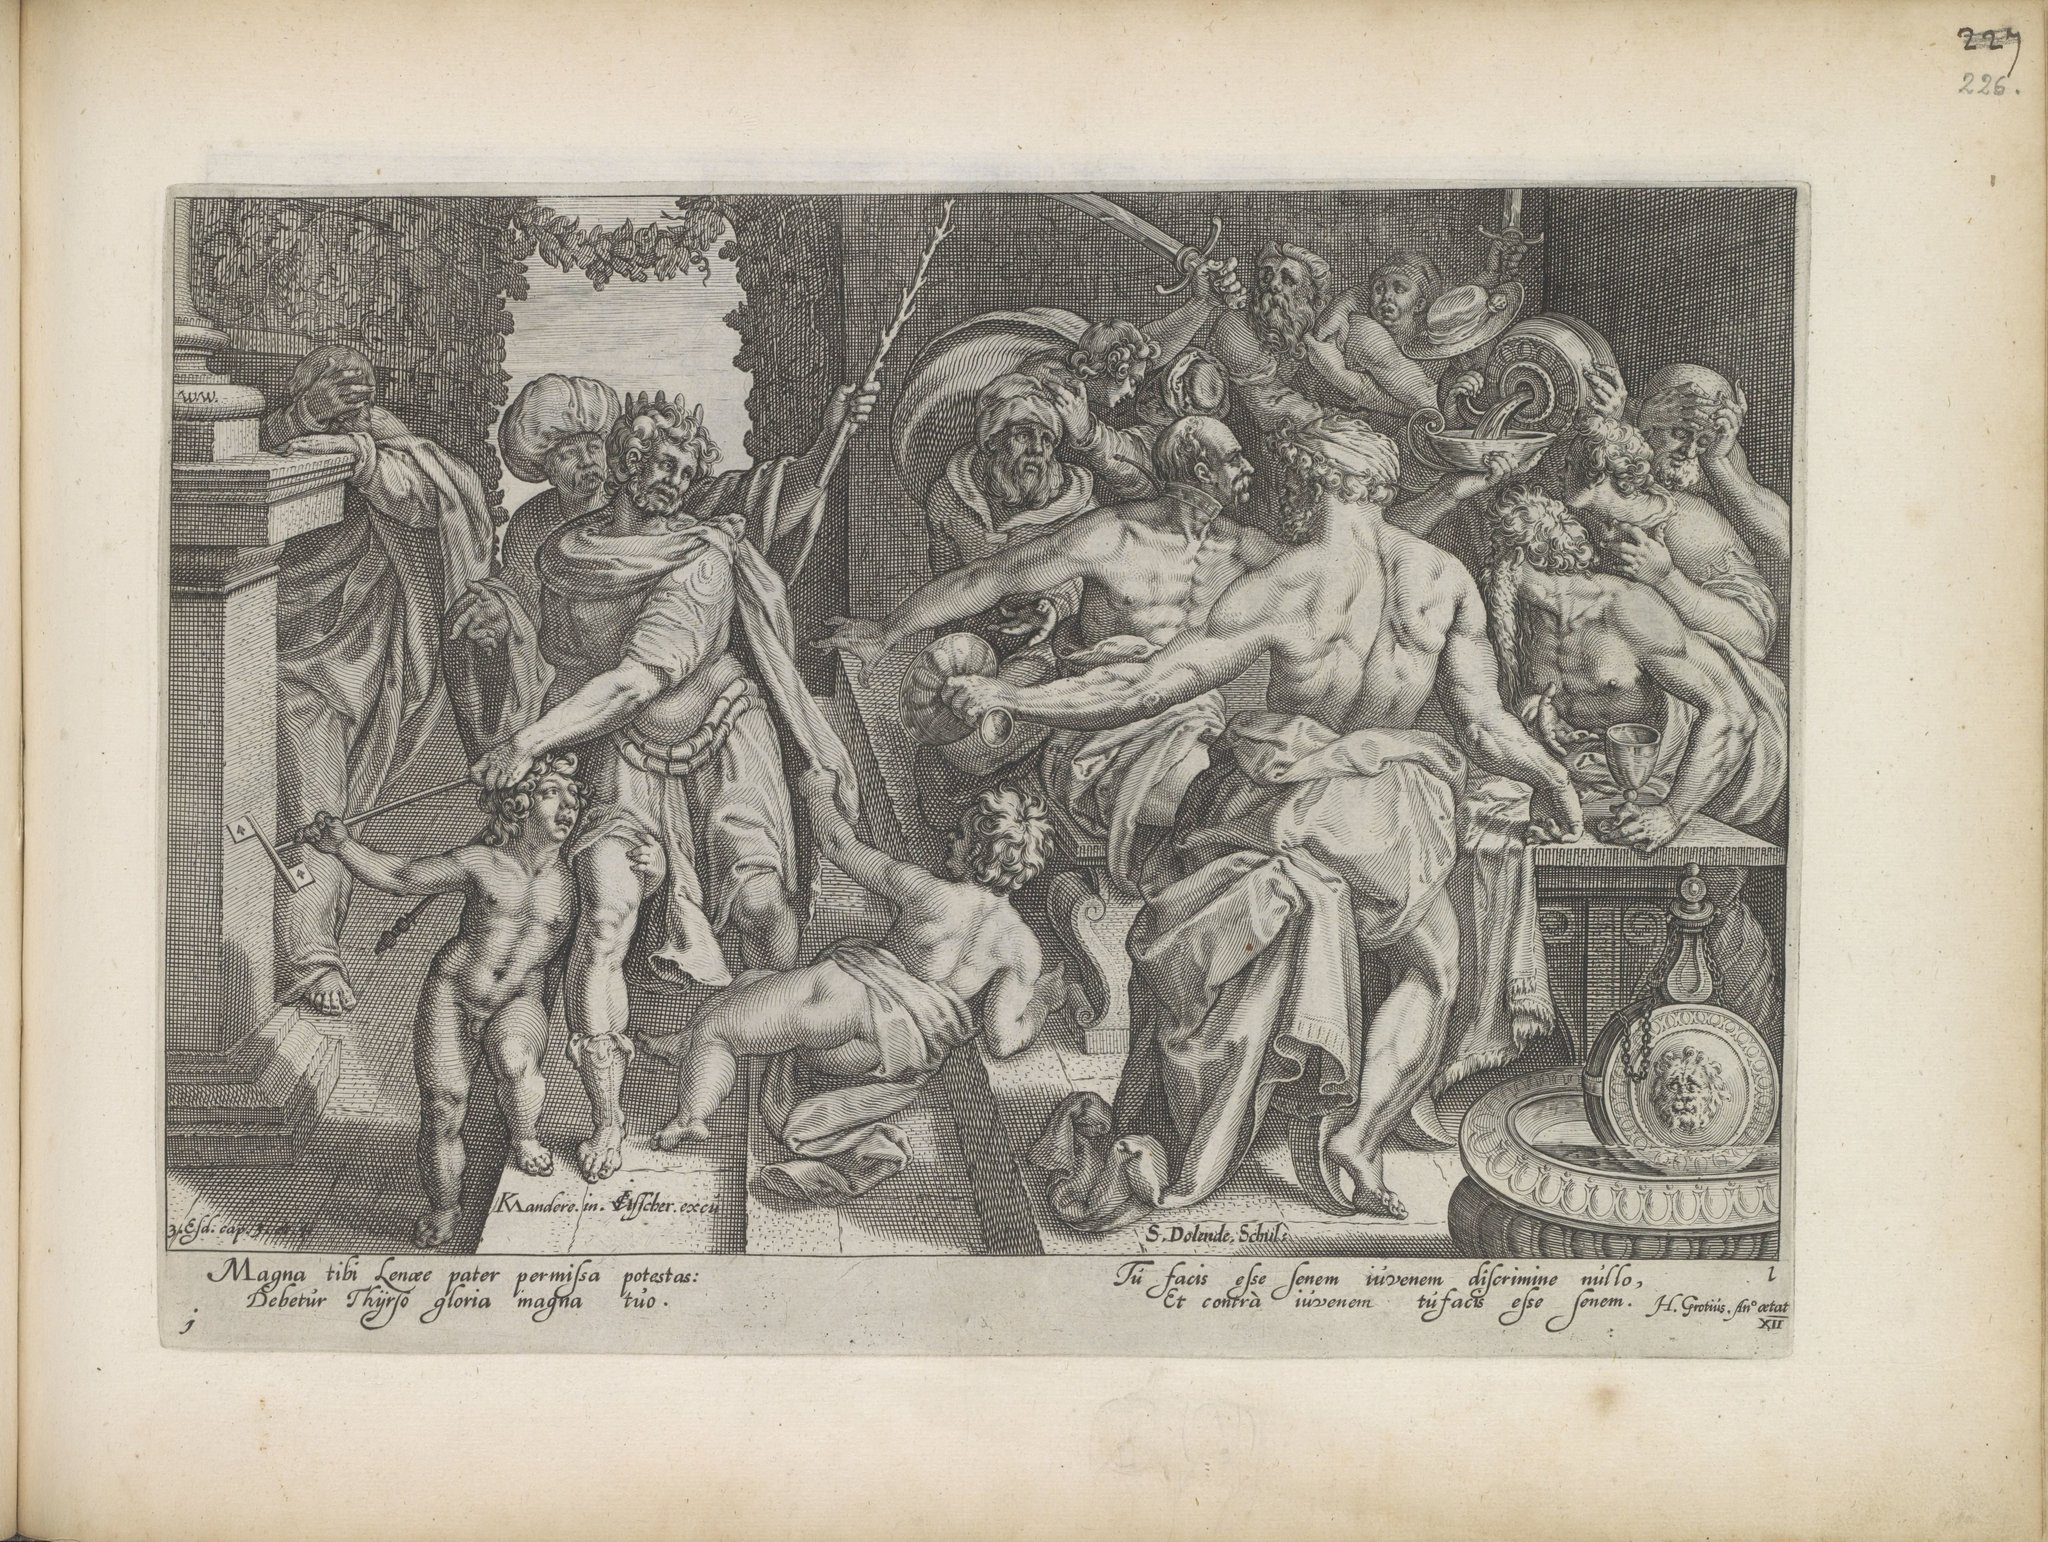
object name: album leaf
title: Macht van wijn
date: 1595-1596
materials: paper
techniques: engraving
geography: amsterdam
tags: the books of ezra, nehemiah, and esdras, wine ~ alcoholic drinks, king, the first guardsman says (writes) that wine is the strongest of all things ~ contest of the three guardsmen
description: De wijn als heerser over de wereld. Rond een tafel drinken mannen wijn. Ook een koning, links, staat onder invloed van wijn. Rondom hem dronken figuren. Linksonder een verwijzing naar de tekst in 3 Esdras 3-4. Onder de voorstelling verzen in het Latijn. Deze prent maakt deel uit van een album.